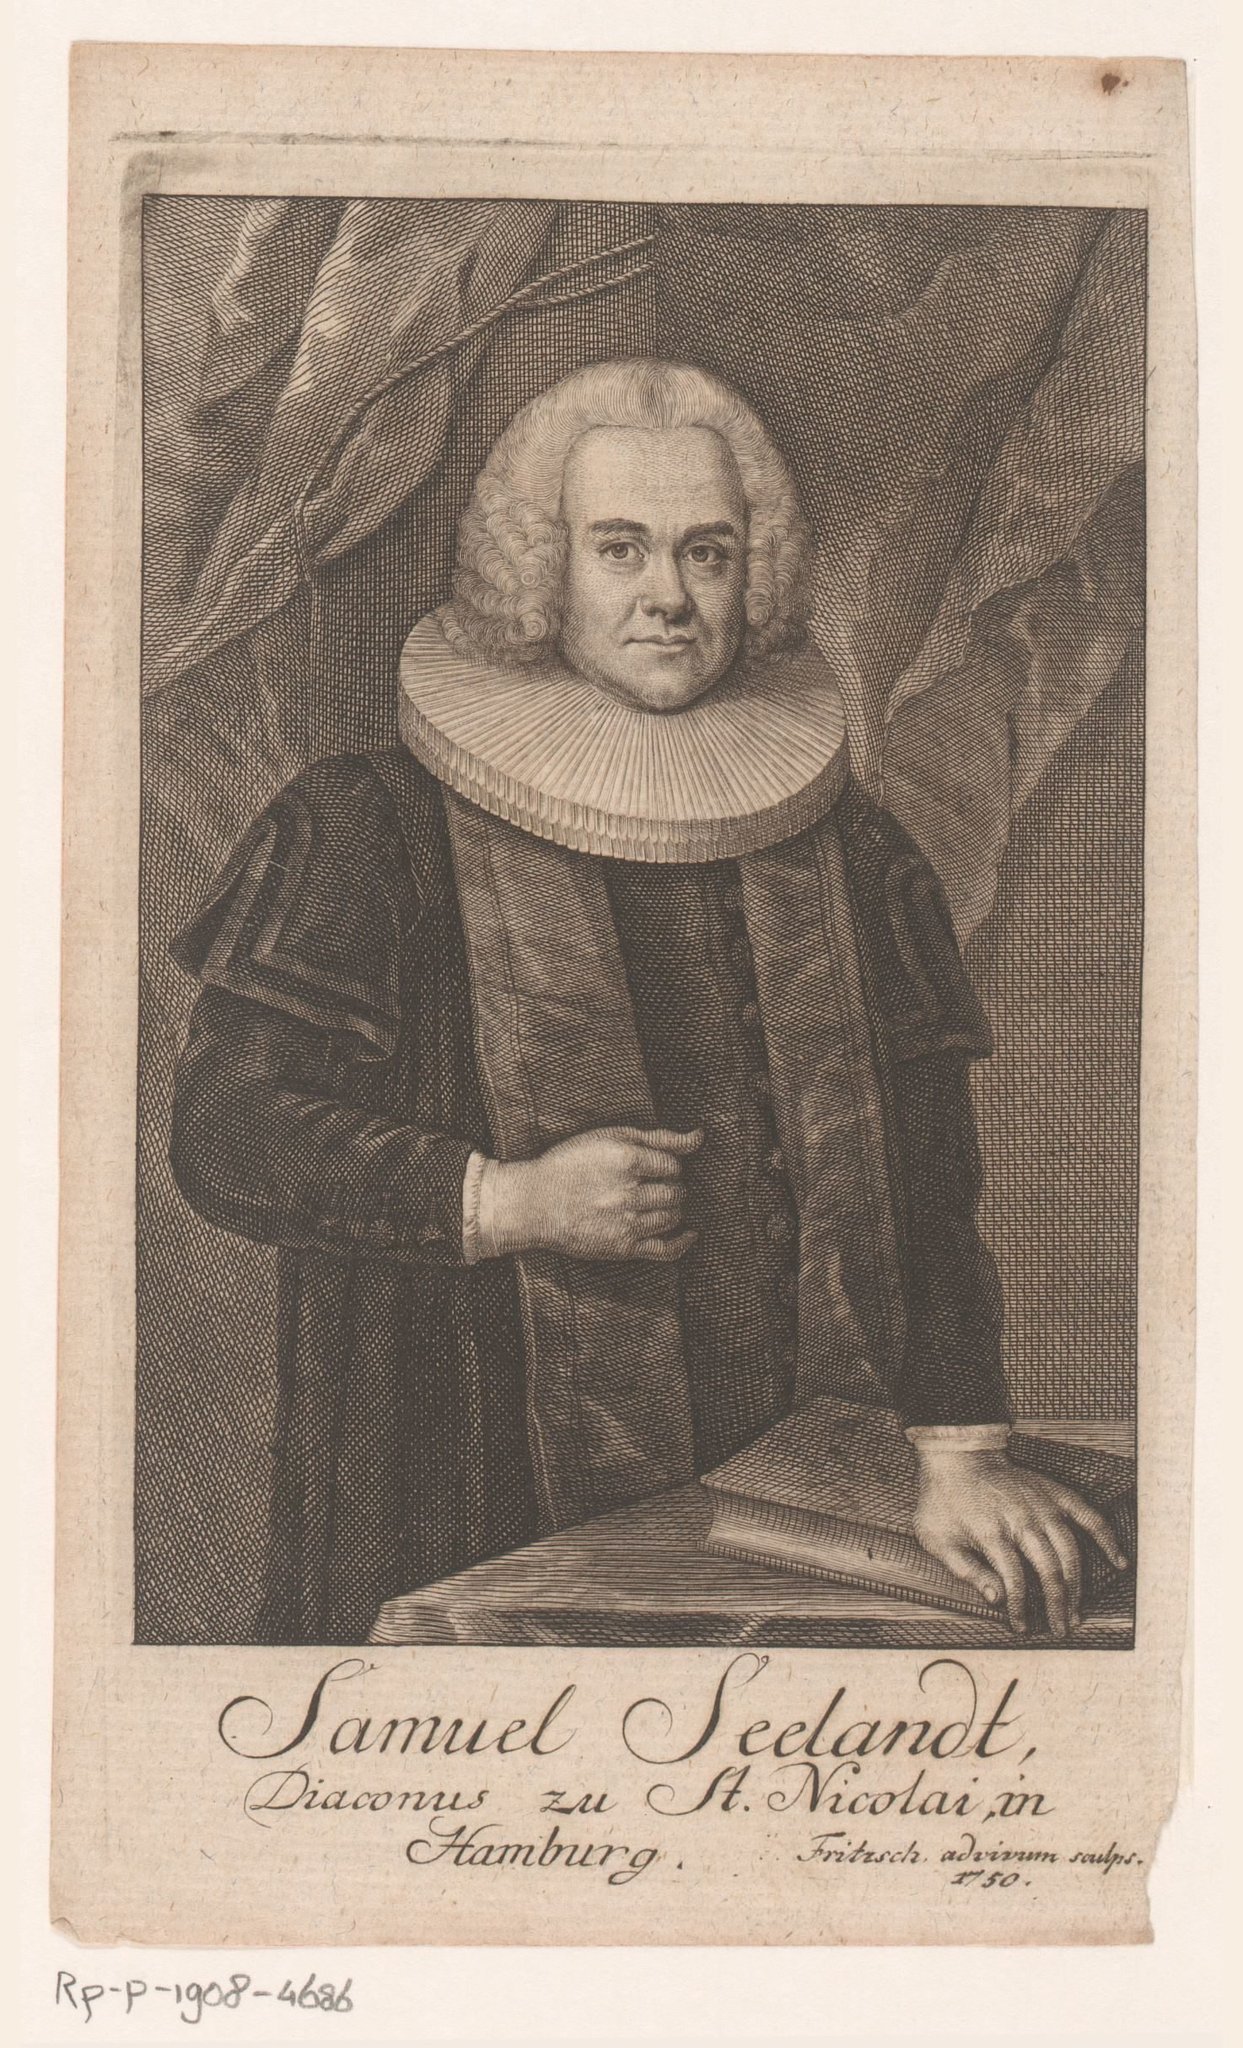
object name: print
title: Portret van Samuel Seelandt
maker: christian fritzsch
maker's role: print maker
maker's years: 1695-1769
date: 1750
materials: paper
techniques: engraving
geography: hamburg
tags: theologian, historical persons, book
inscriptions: collector's mark: Lugt 2228